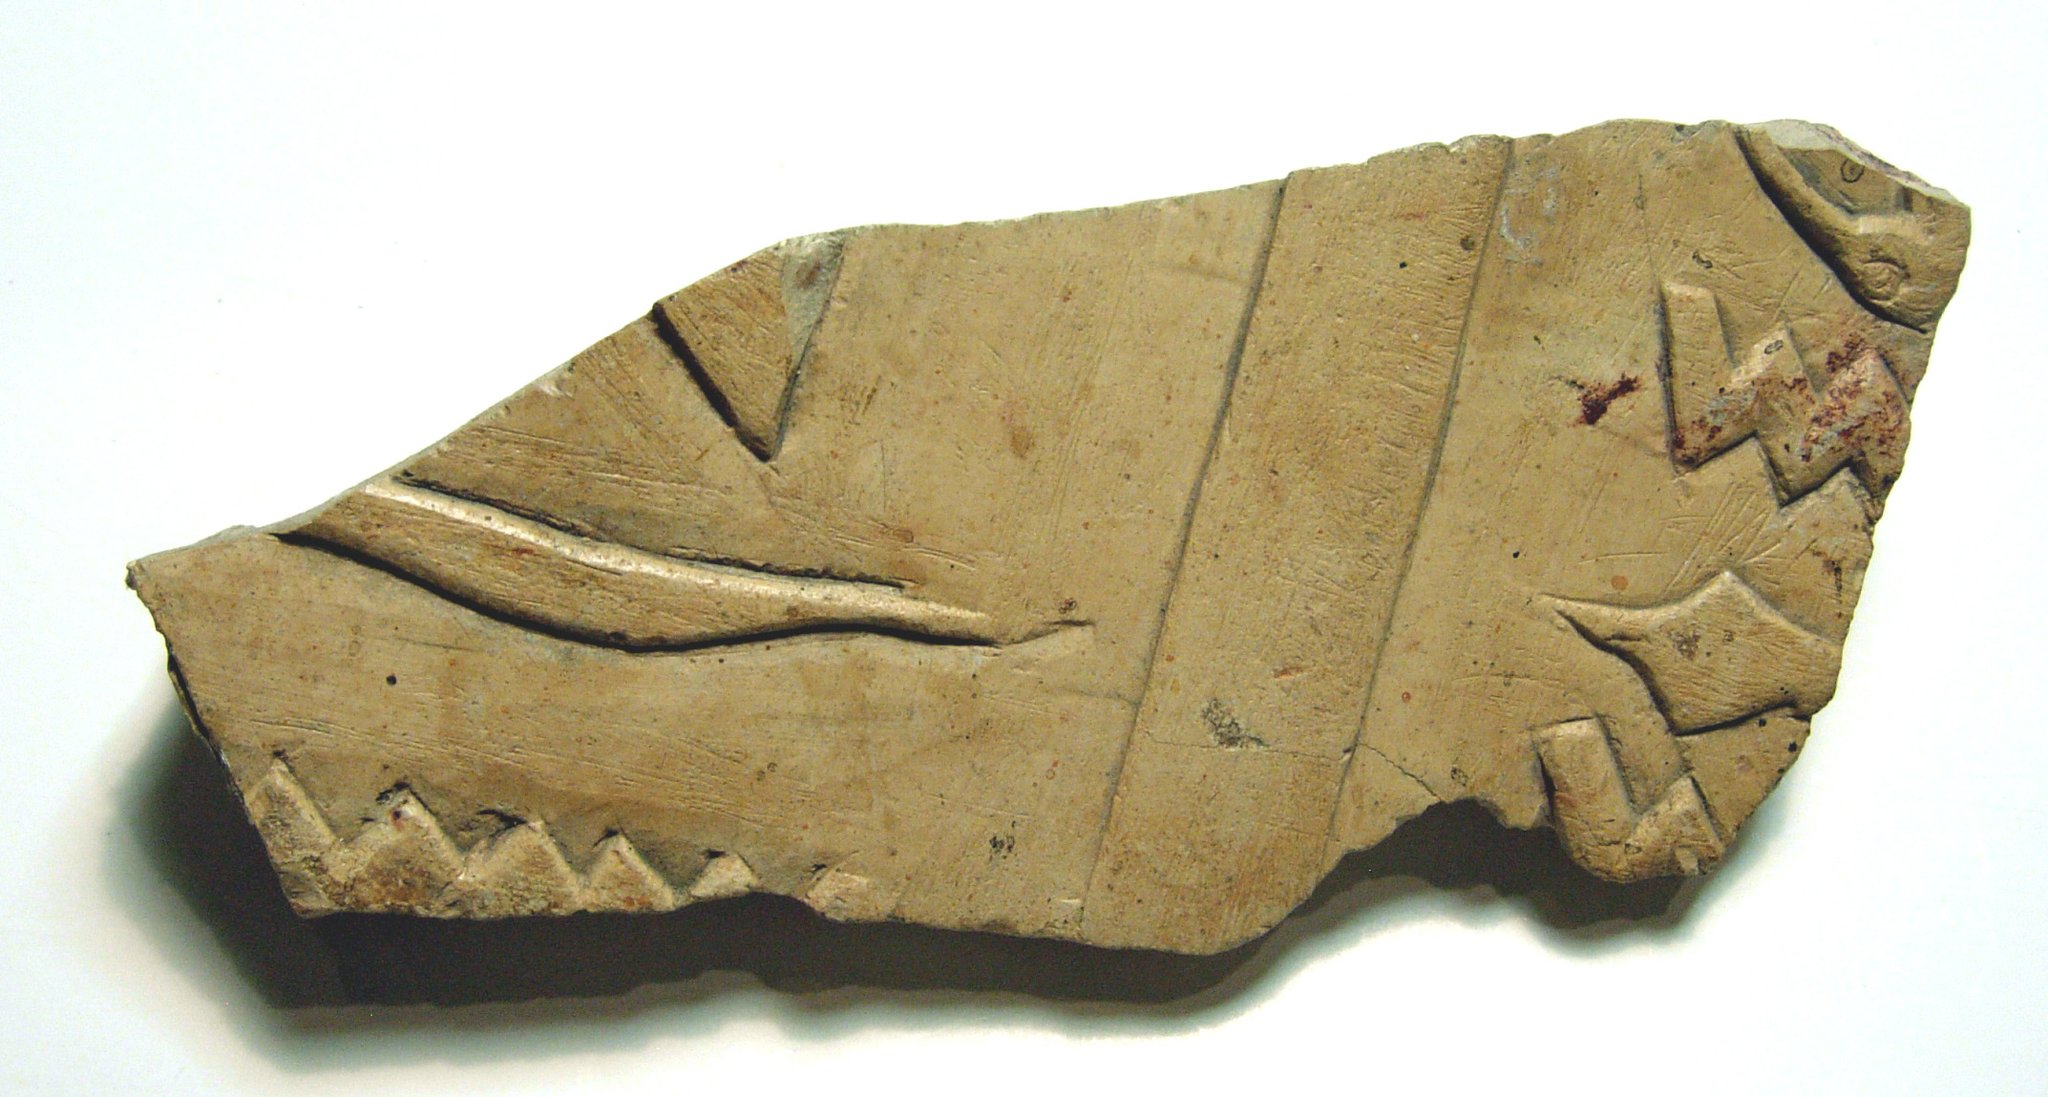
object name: relief, tomb of nespekashuty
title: Raised relief fragment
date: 664-610 BCE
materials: limestone, varnish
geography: egypt